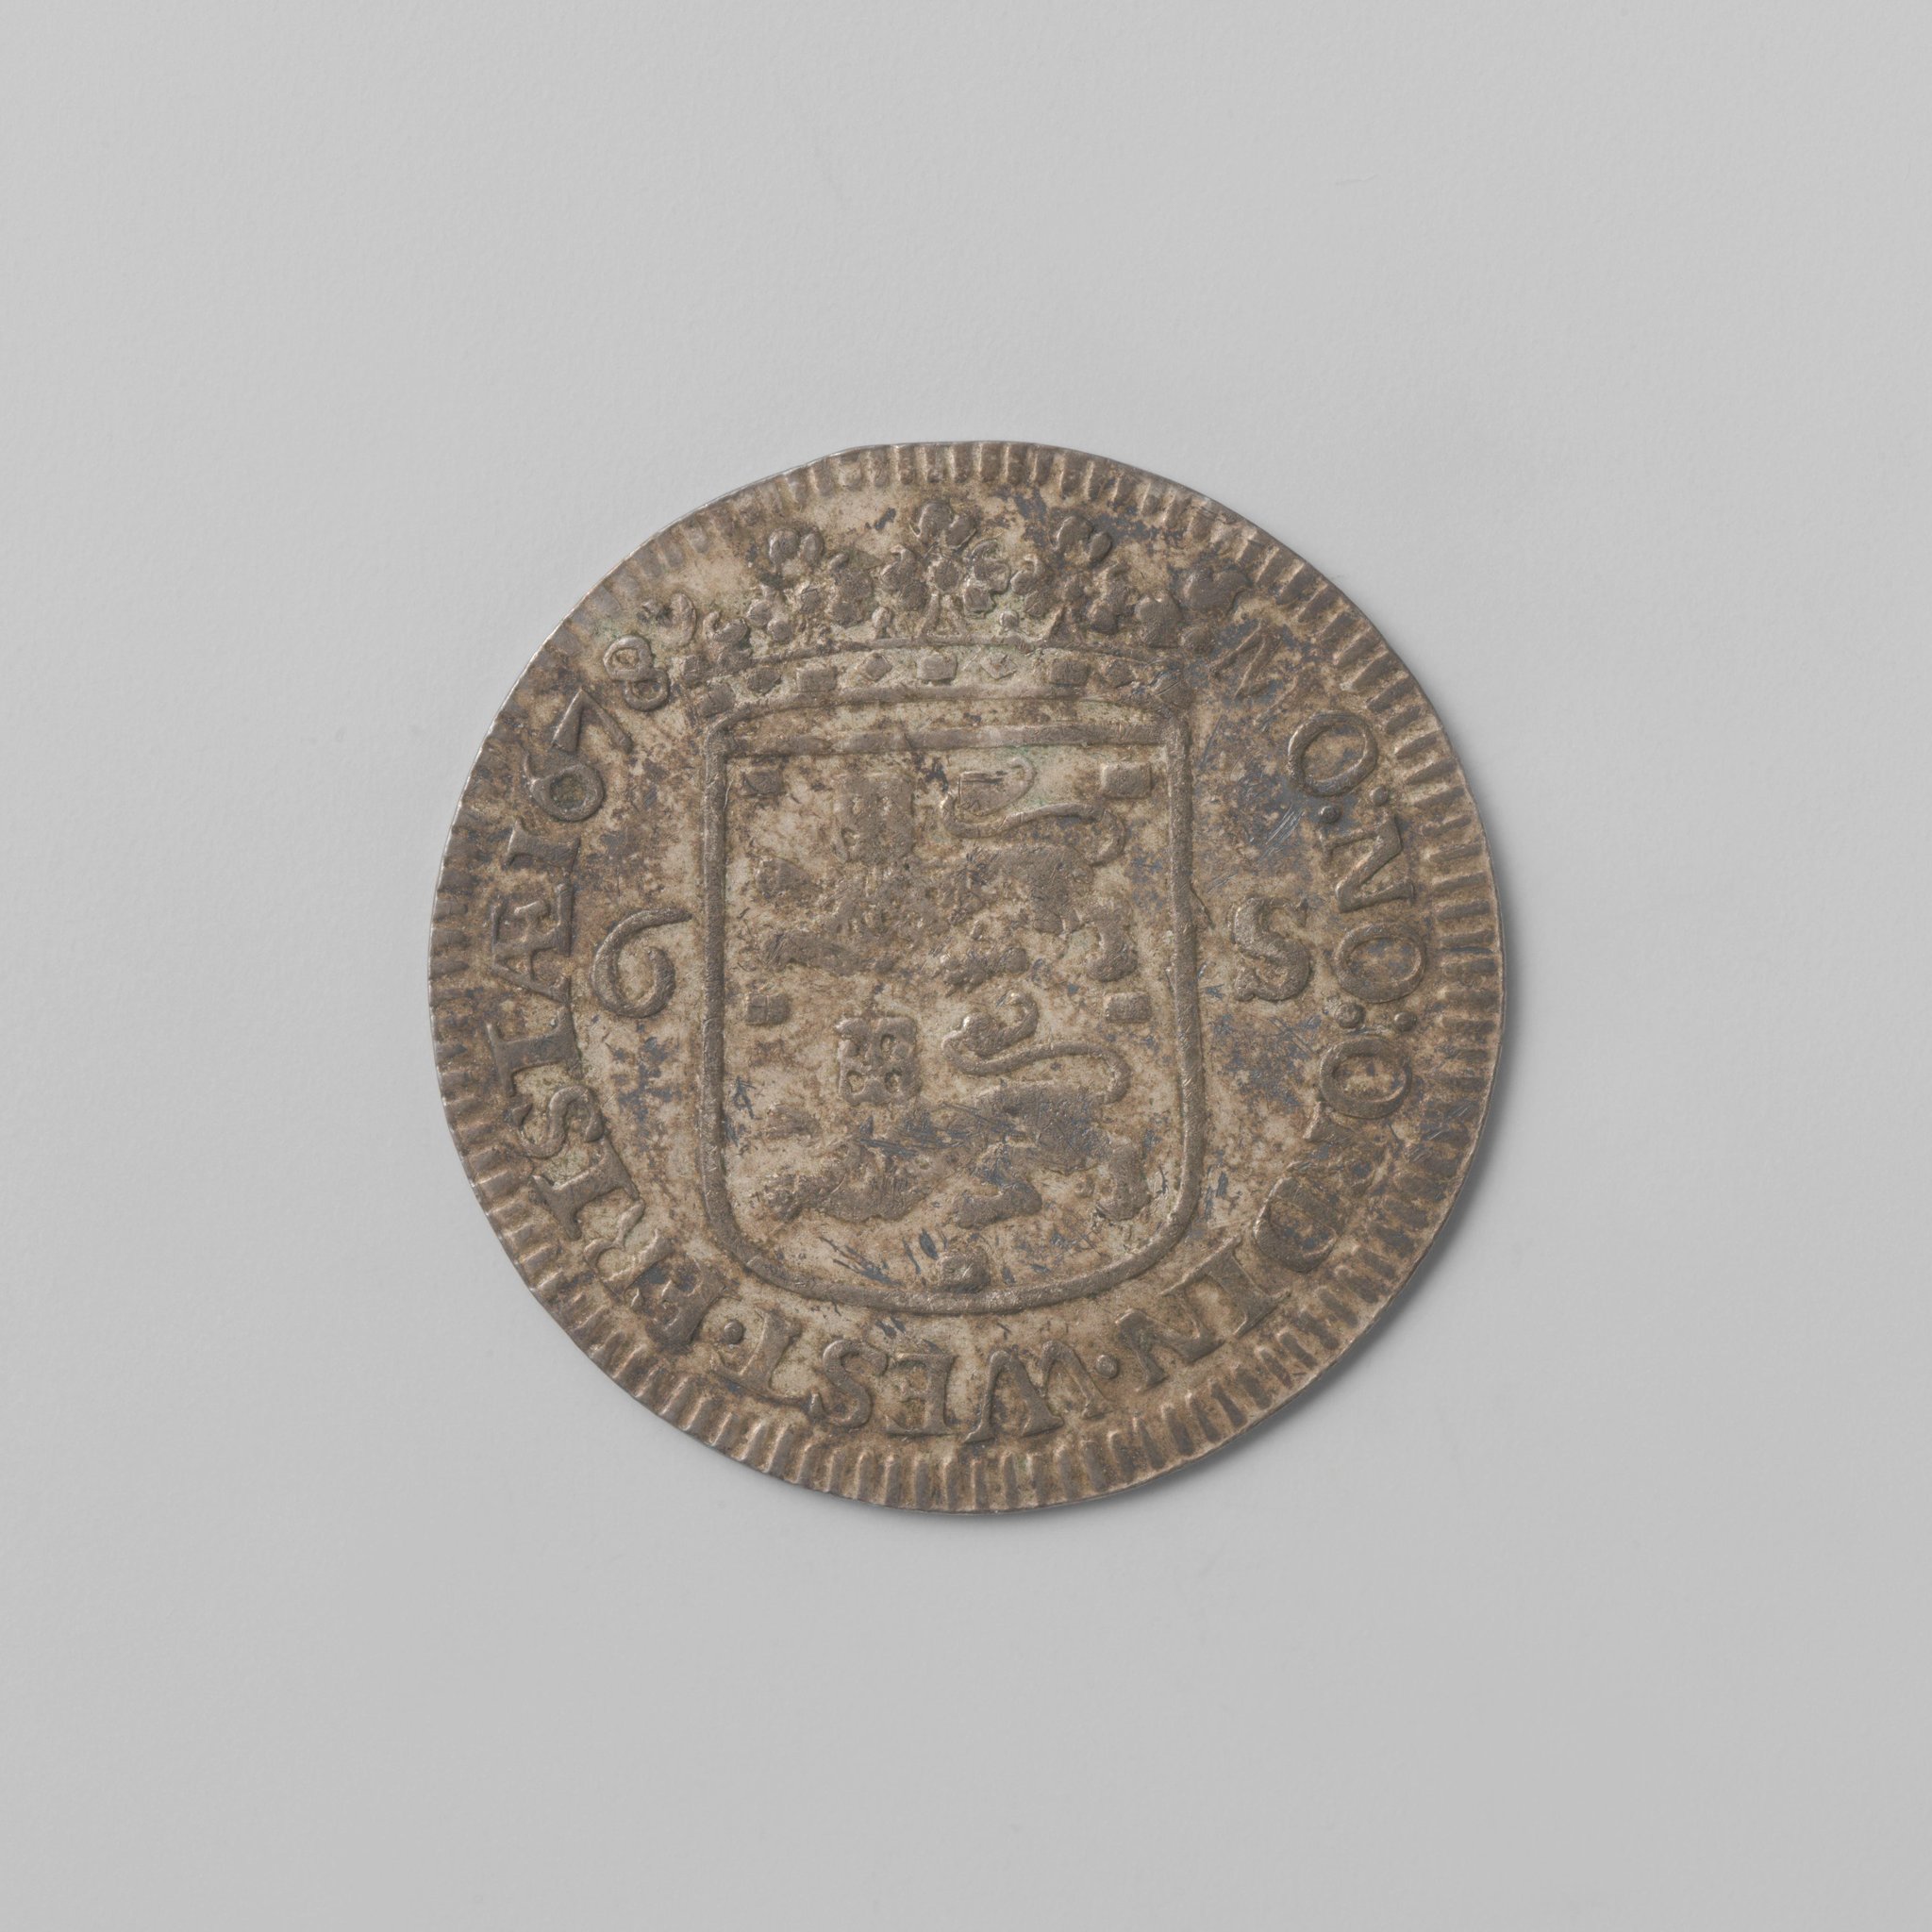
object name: coin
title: West-Friesland, scheepjesschelling, 1678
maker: dirck bosch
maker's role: mintmaster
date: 1678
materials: silver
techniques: striking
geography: enkhuizen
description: Zilveren munt. Voorzijde: tussen waarde-aanduiding 6 S gekroond wapenschild van West-Friesland. Keerzijde: schip met zeilen naar rechts.